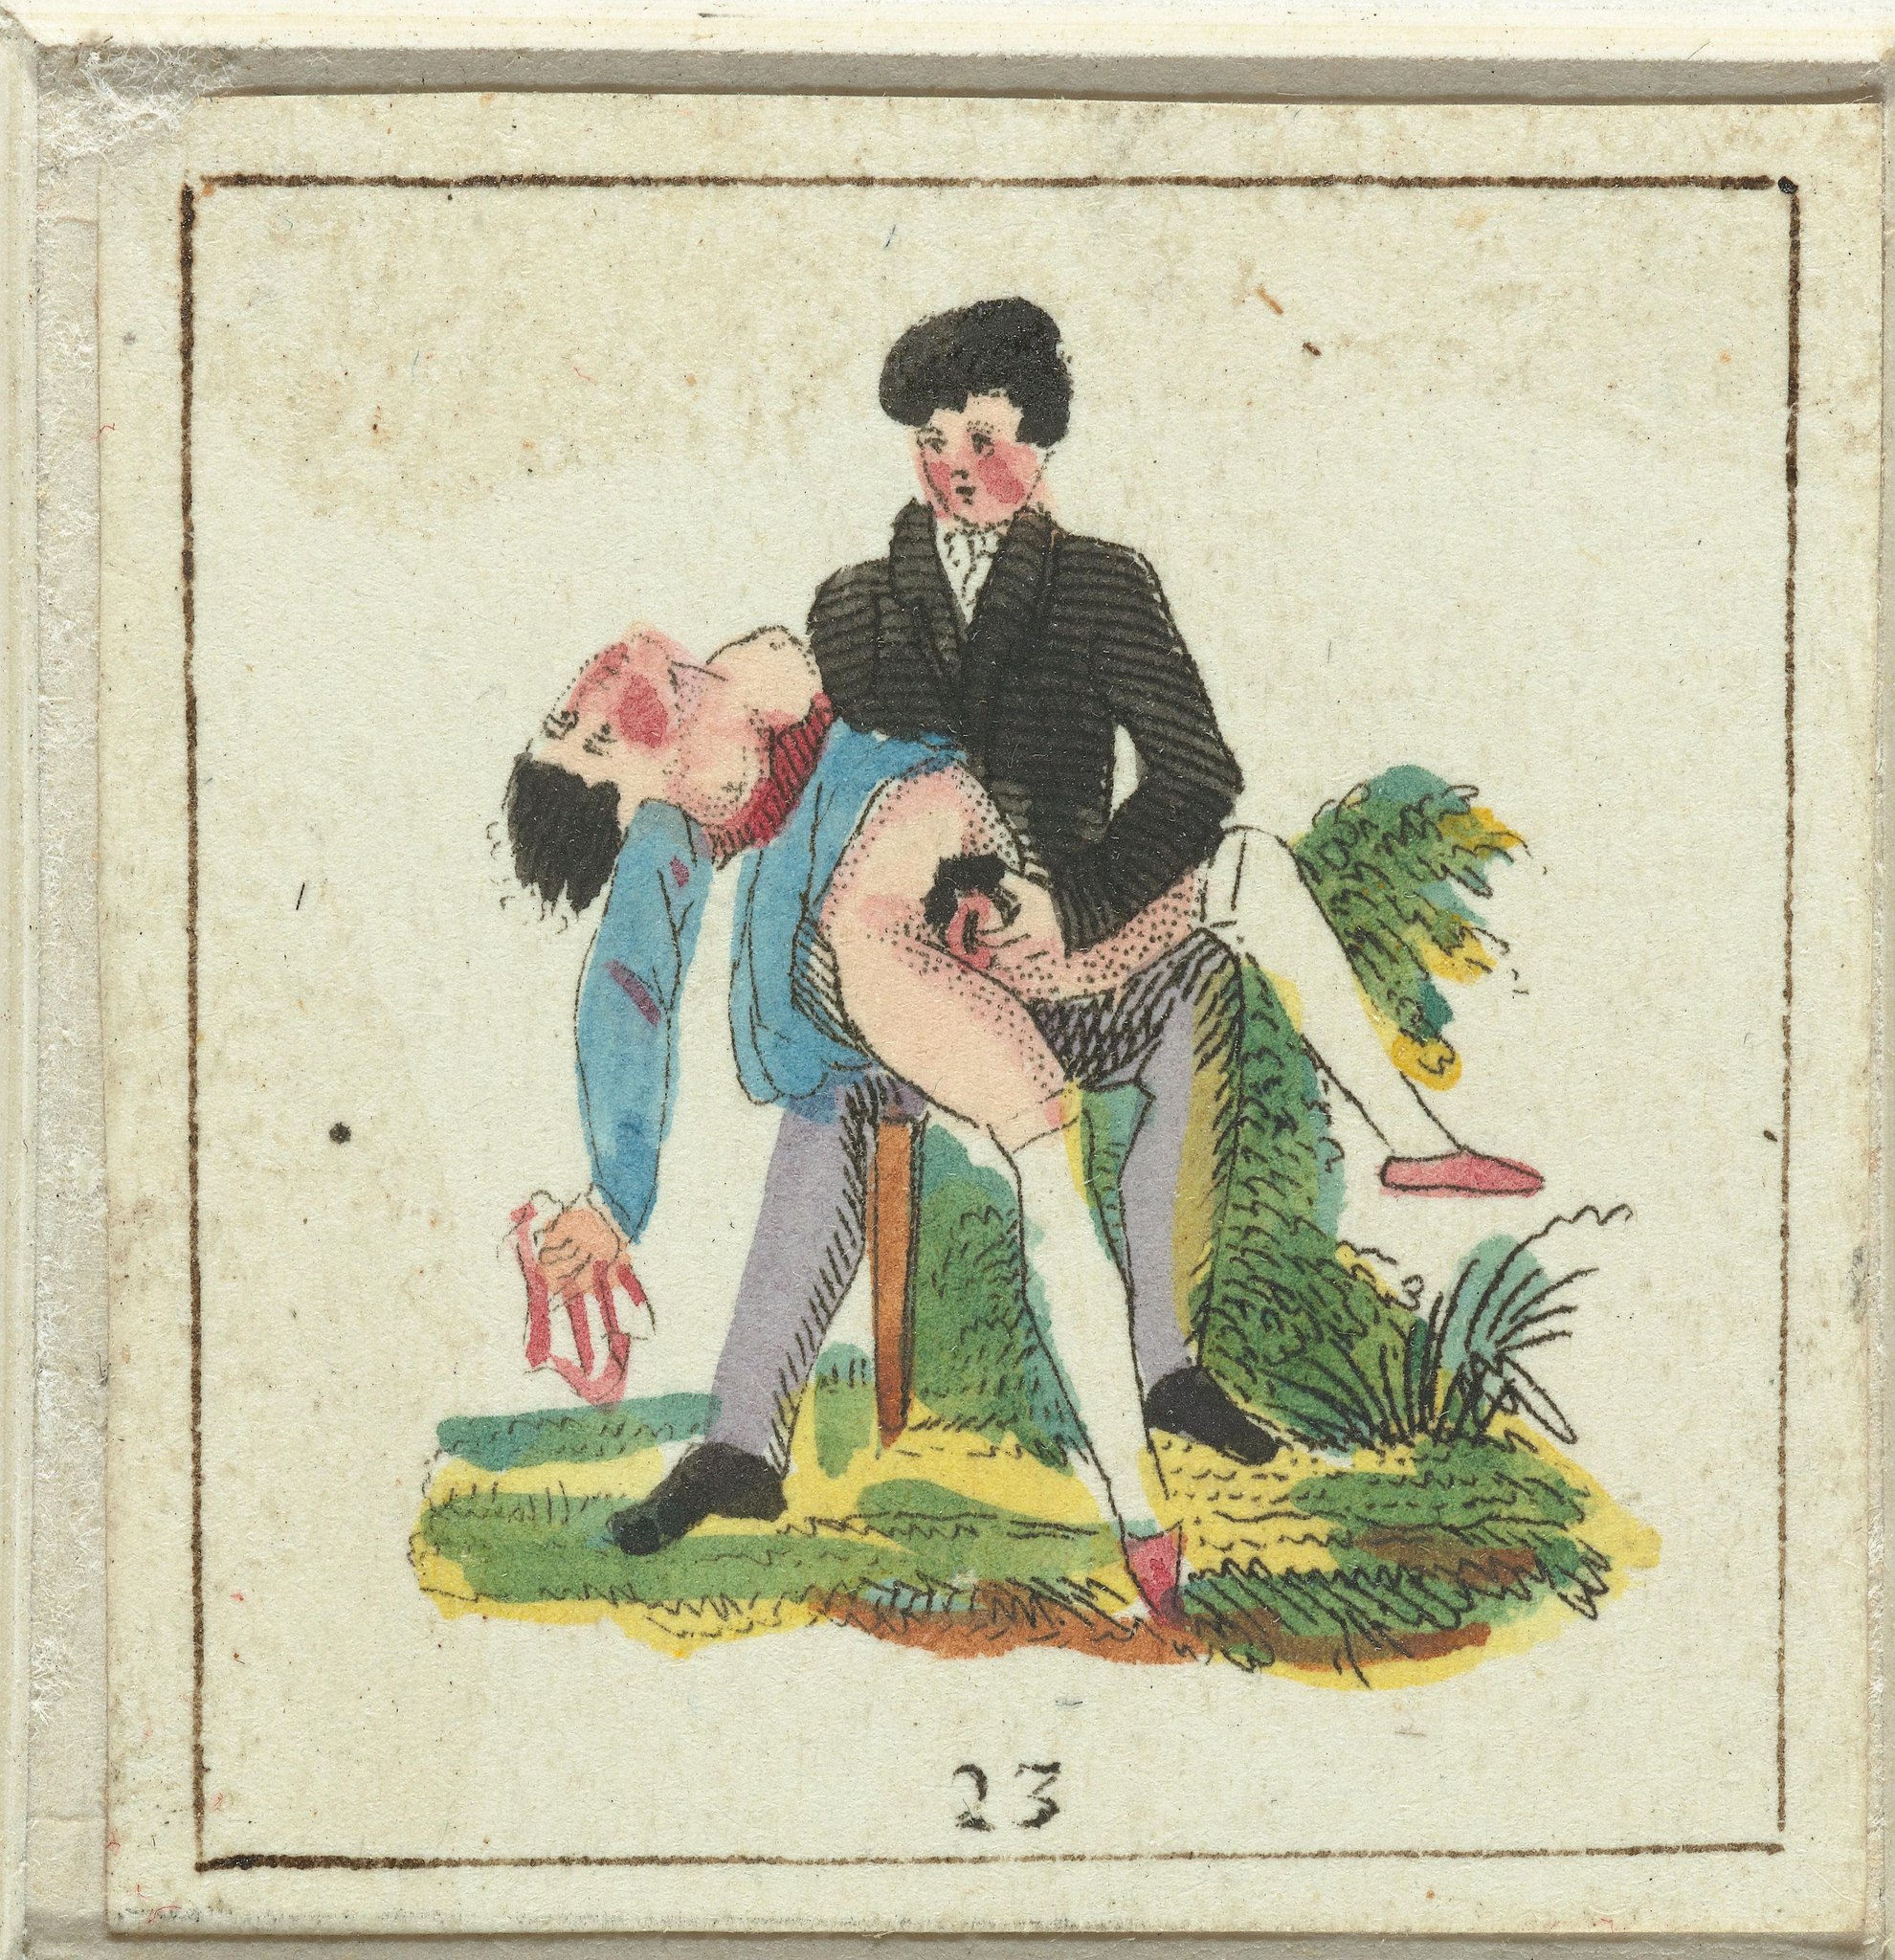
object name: print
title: Vrijend paar in een bosje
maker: Anonymous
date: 1750-1850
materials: paper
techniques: etching, hand coloring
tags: man and woman cohabiting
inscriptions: number: ‘23’